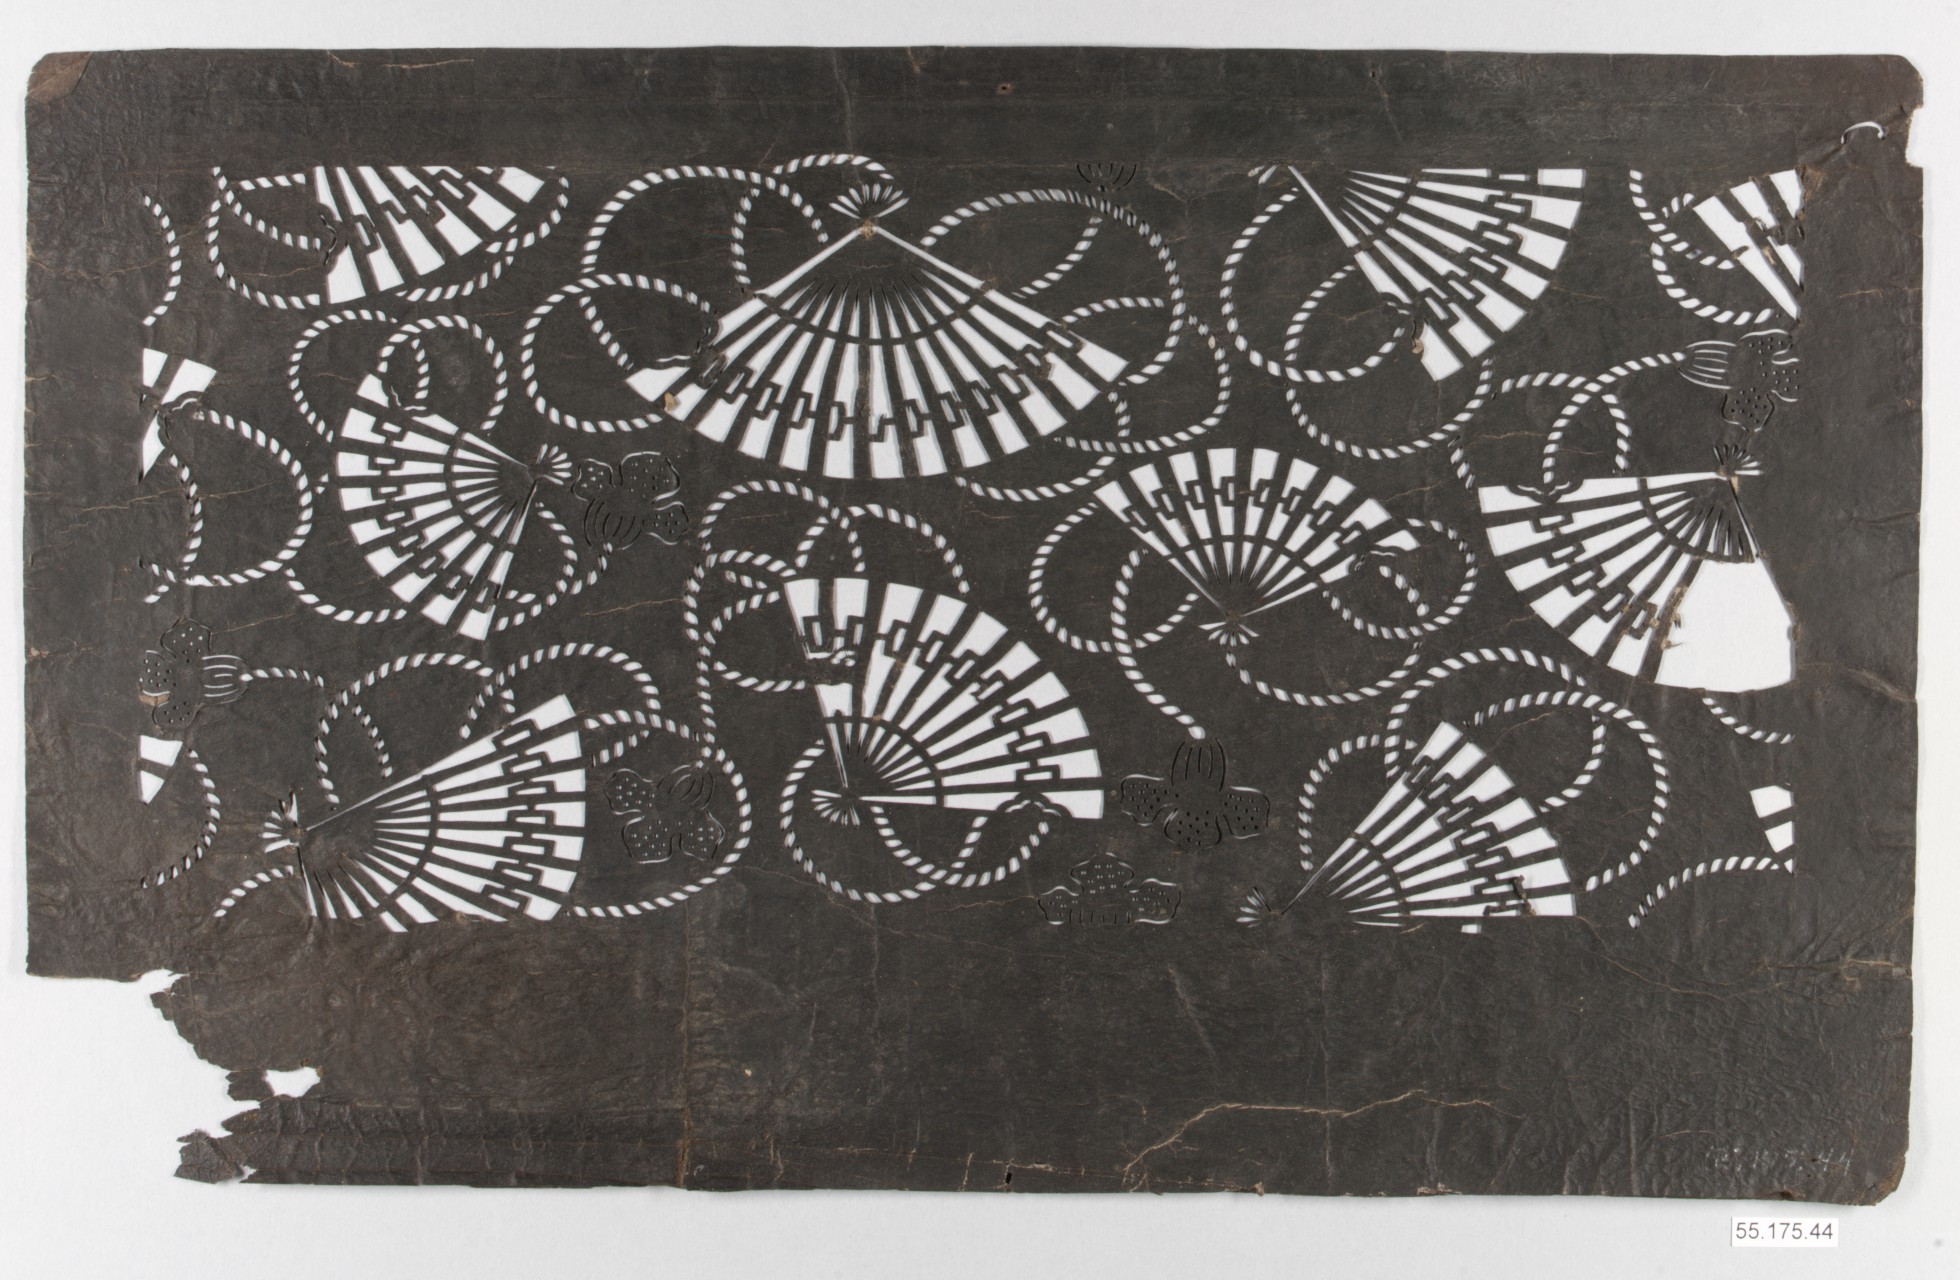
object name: stencil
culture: japanese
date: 1801-1900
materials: paper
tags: fans